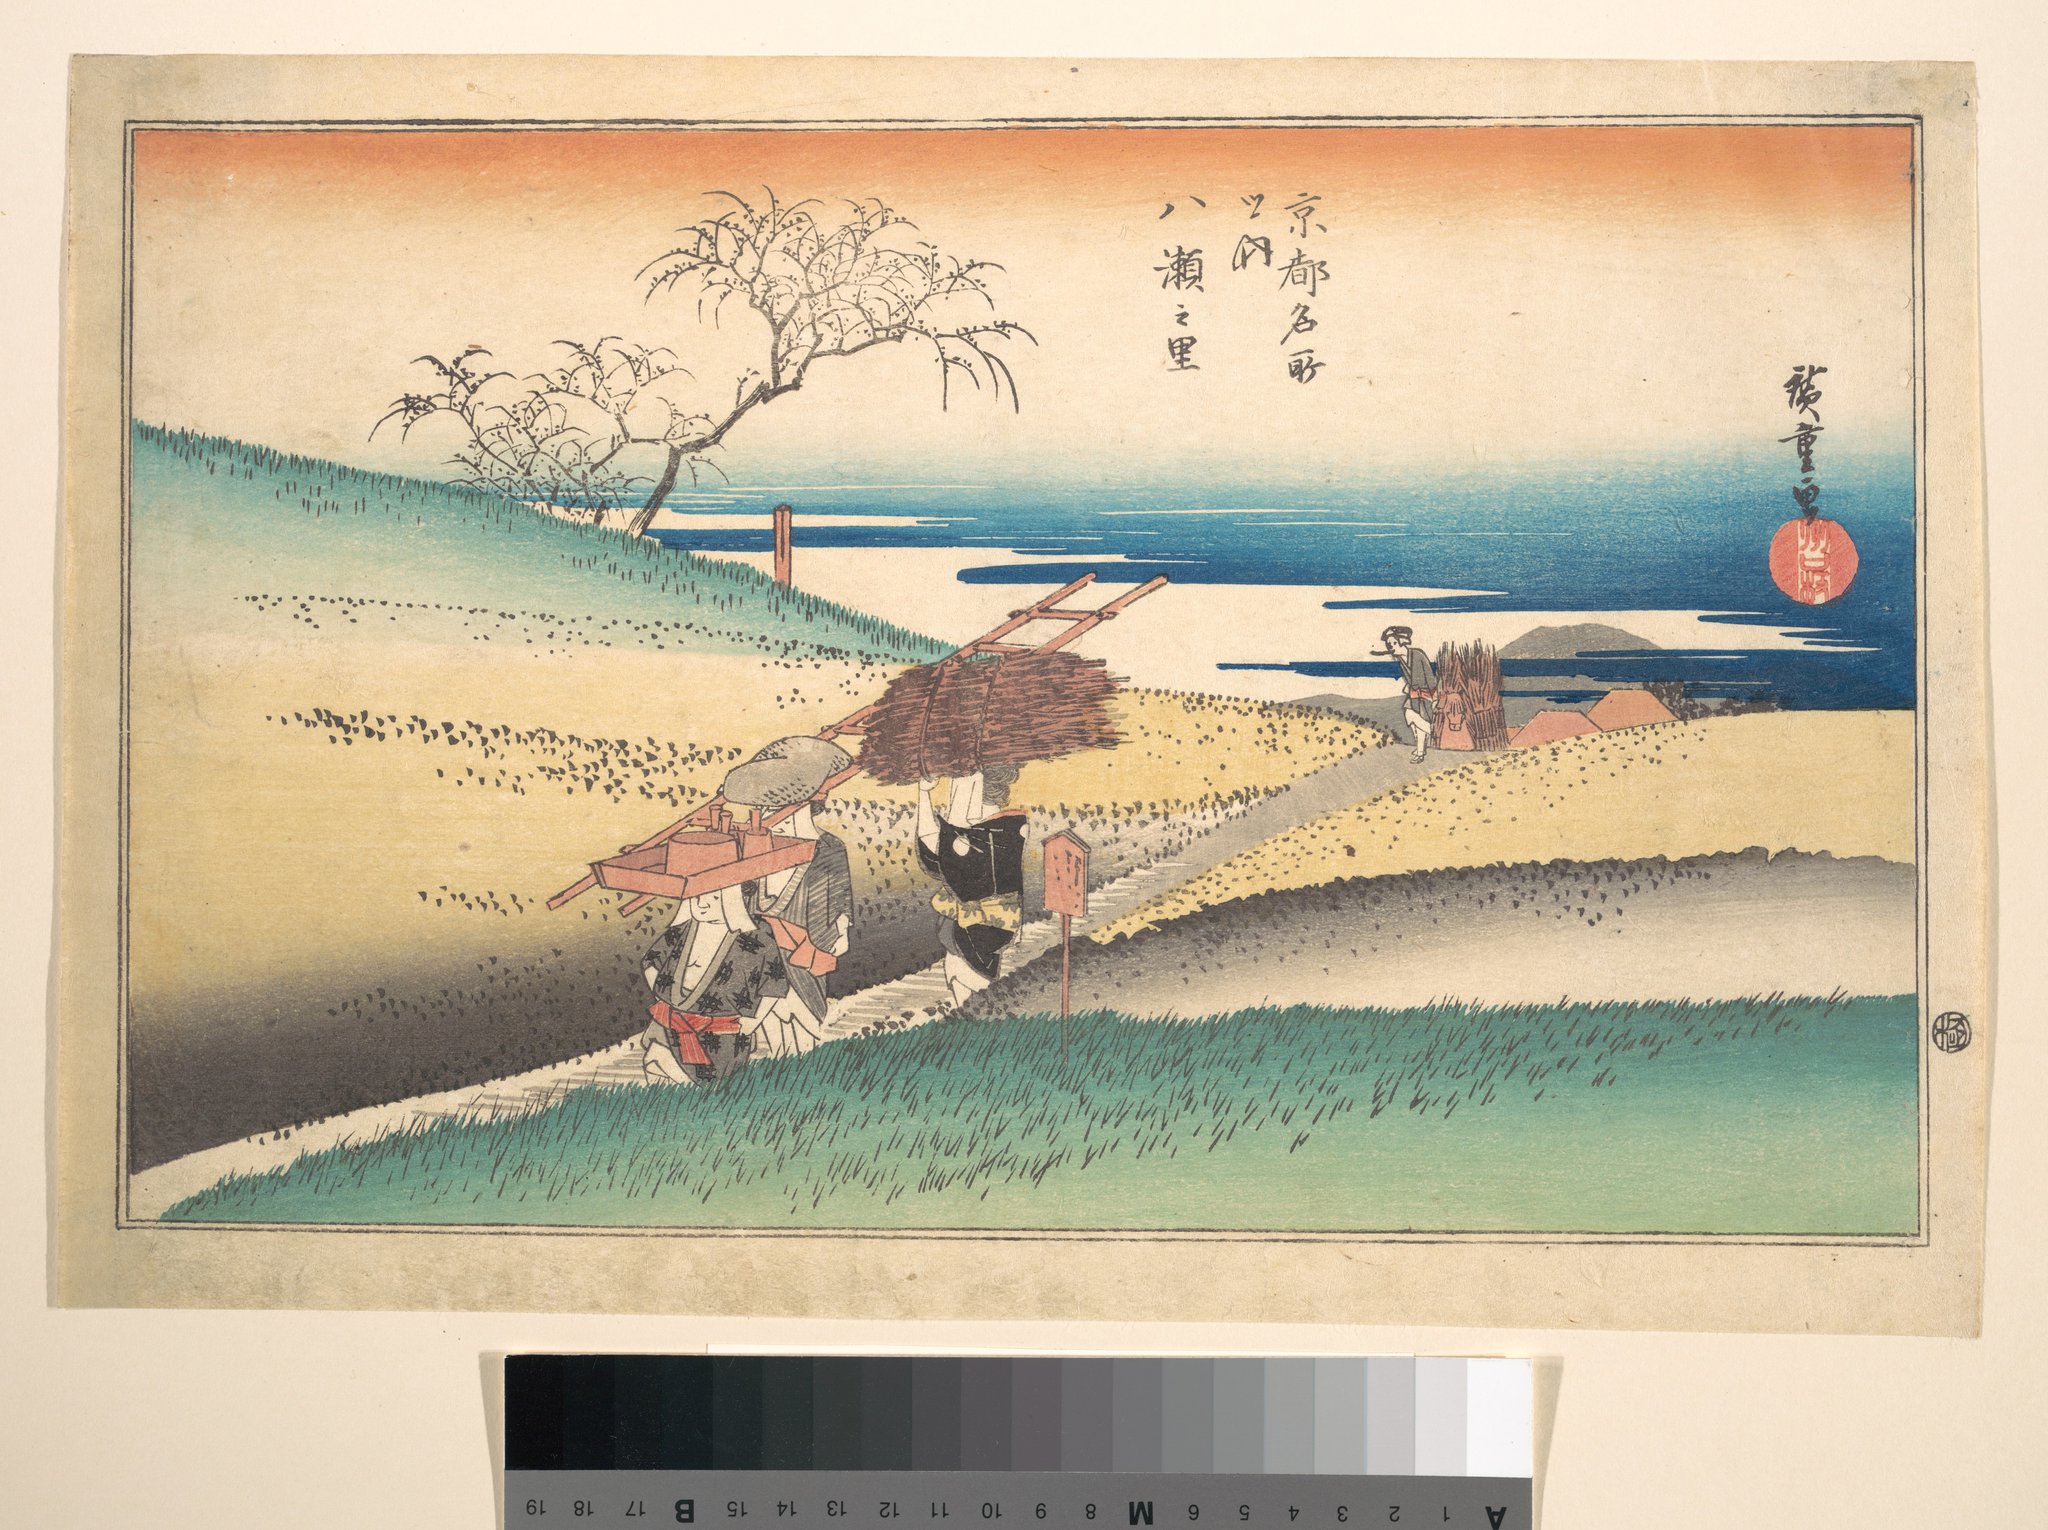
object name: print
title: Village of Yase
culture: japanese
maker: utagawa hiroshige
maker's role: artist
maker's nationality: japanese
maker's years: 1797-1858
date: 1832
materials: ink, paper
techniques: woodblock print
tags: human figures,trees,ladders